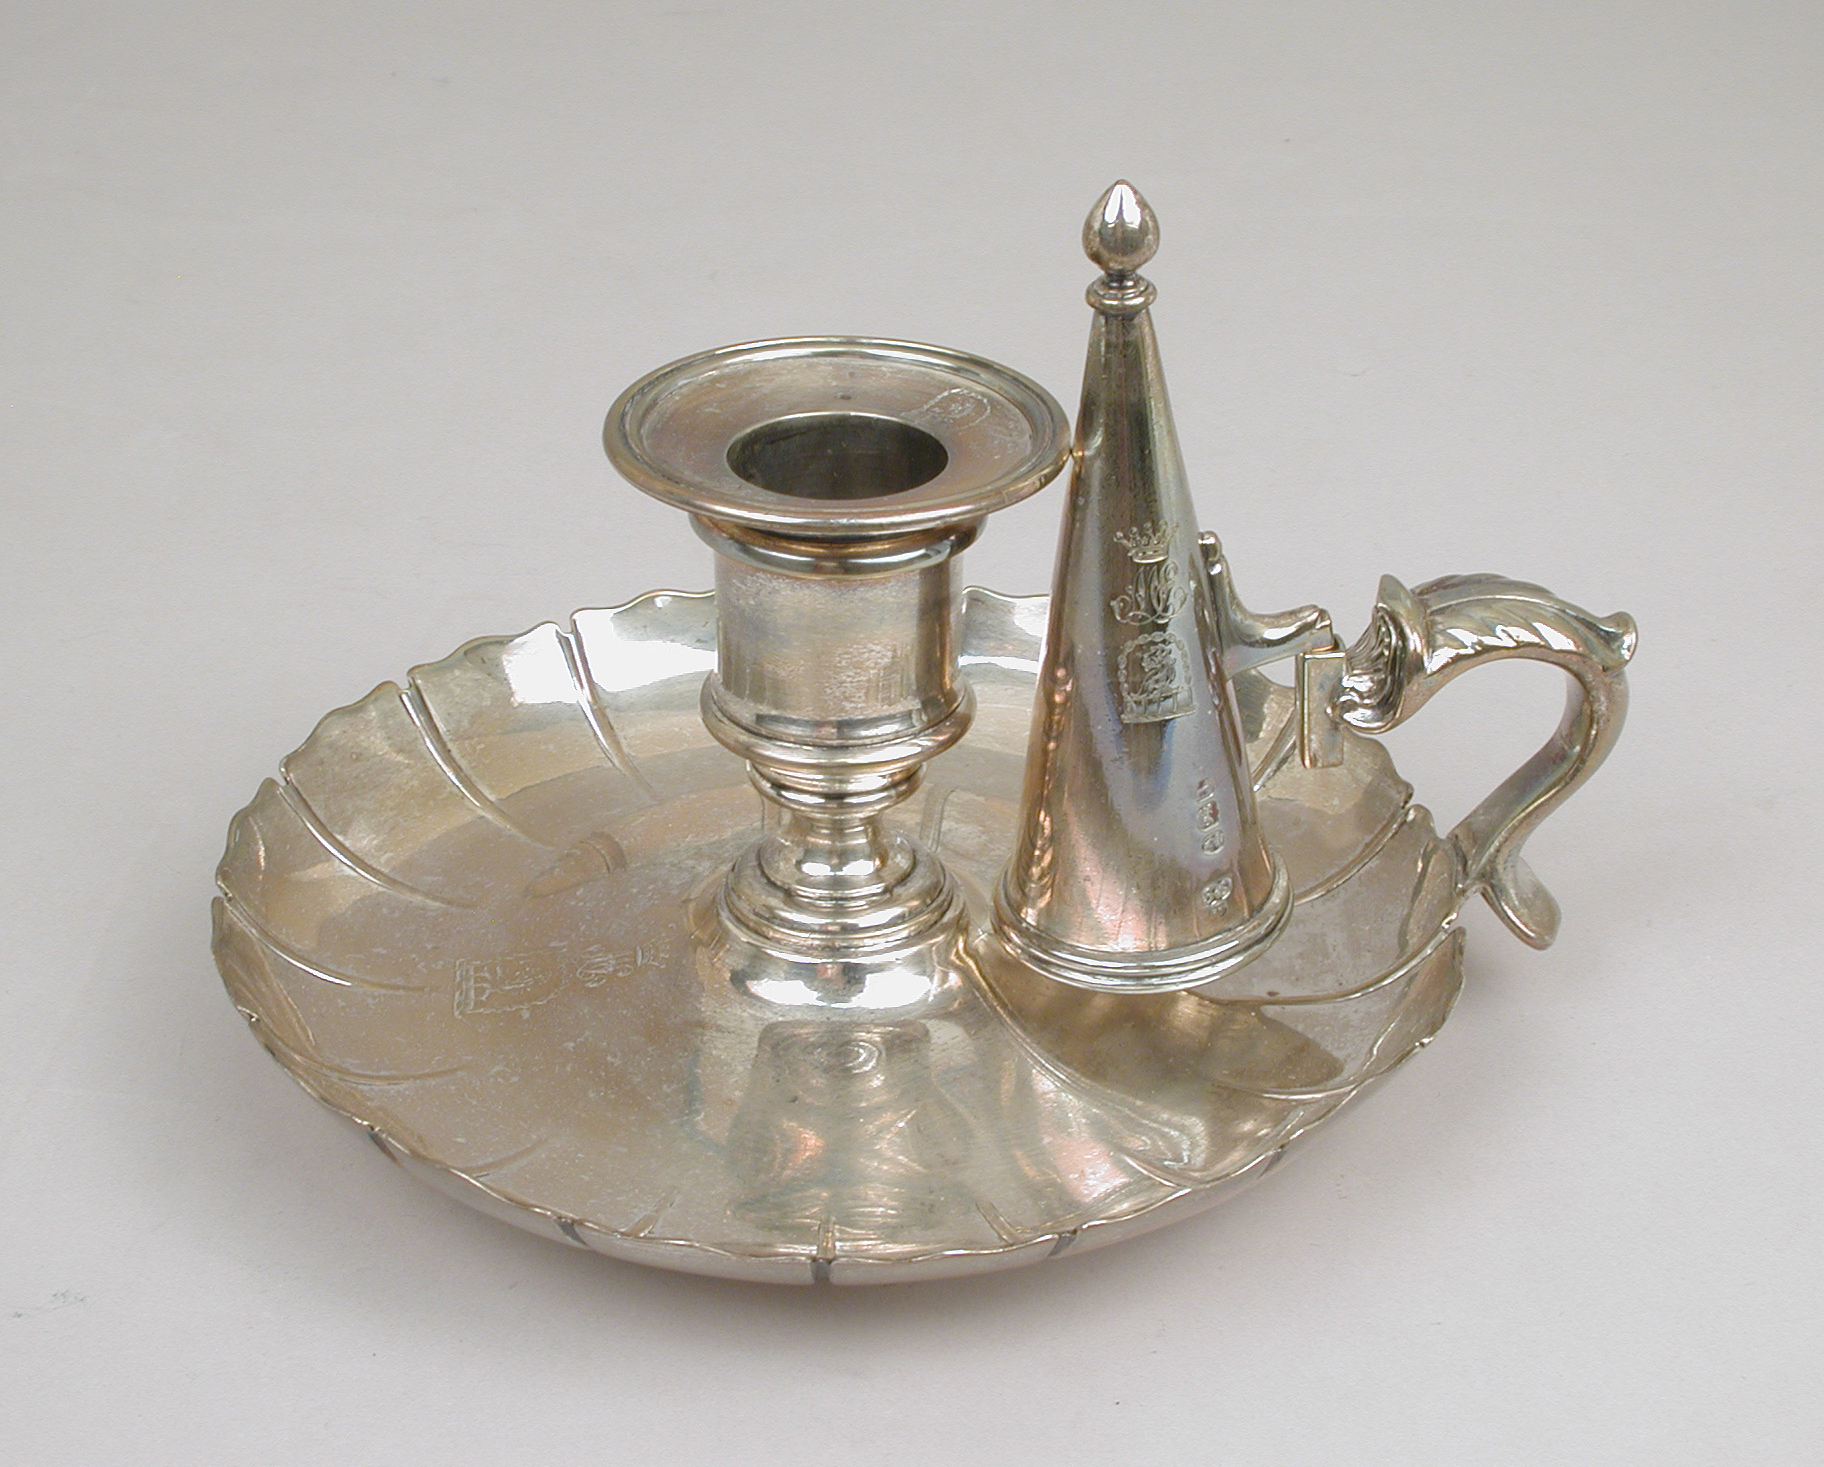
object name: chamber candlestick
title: Chamber candlestick (one of a pair)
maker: robert garrard ii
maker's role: maker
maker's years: 1818-1847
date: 1834-1866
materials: silver